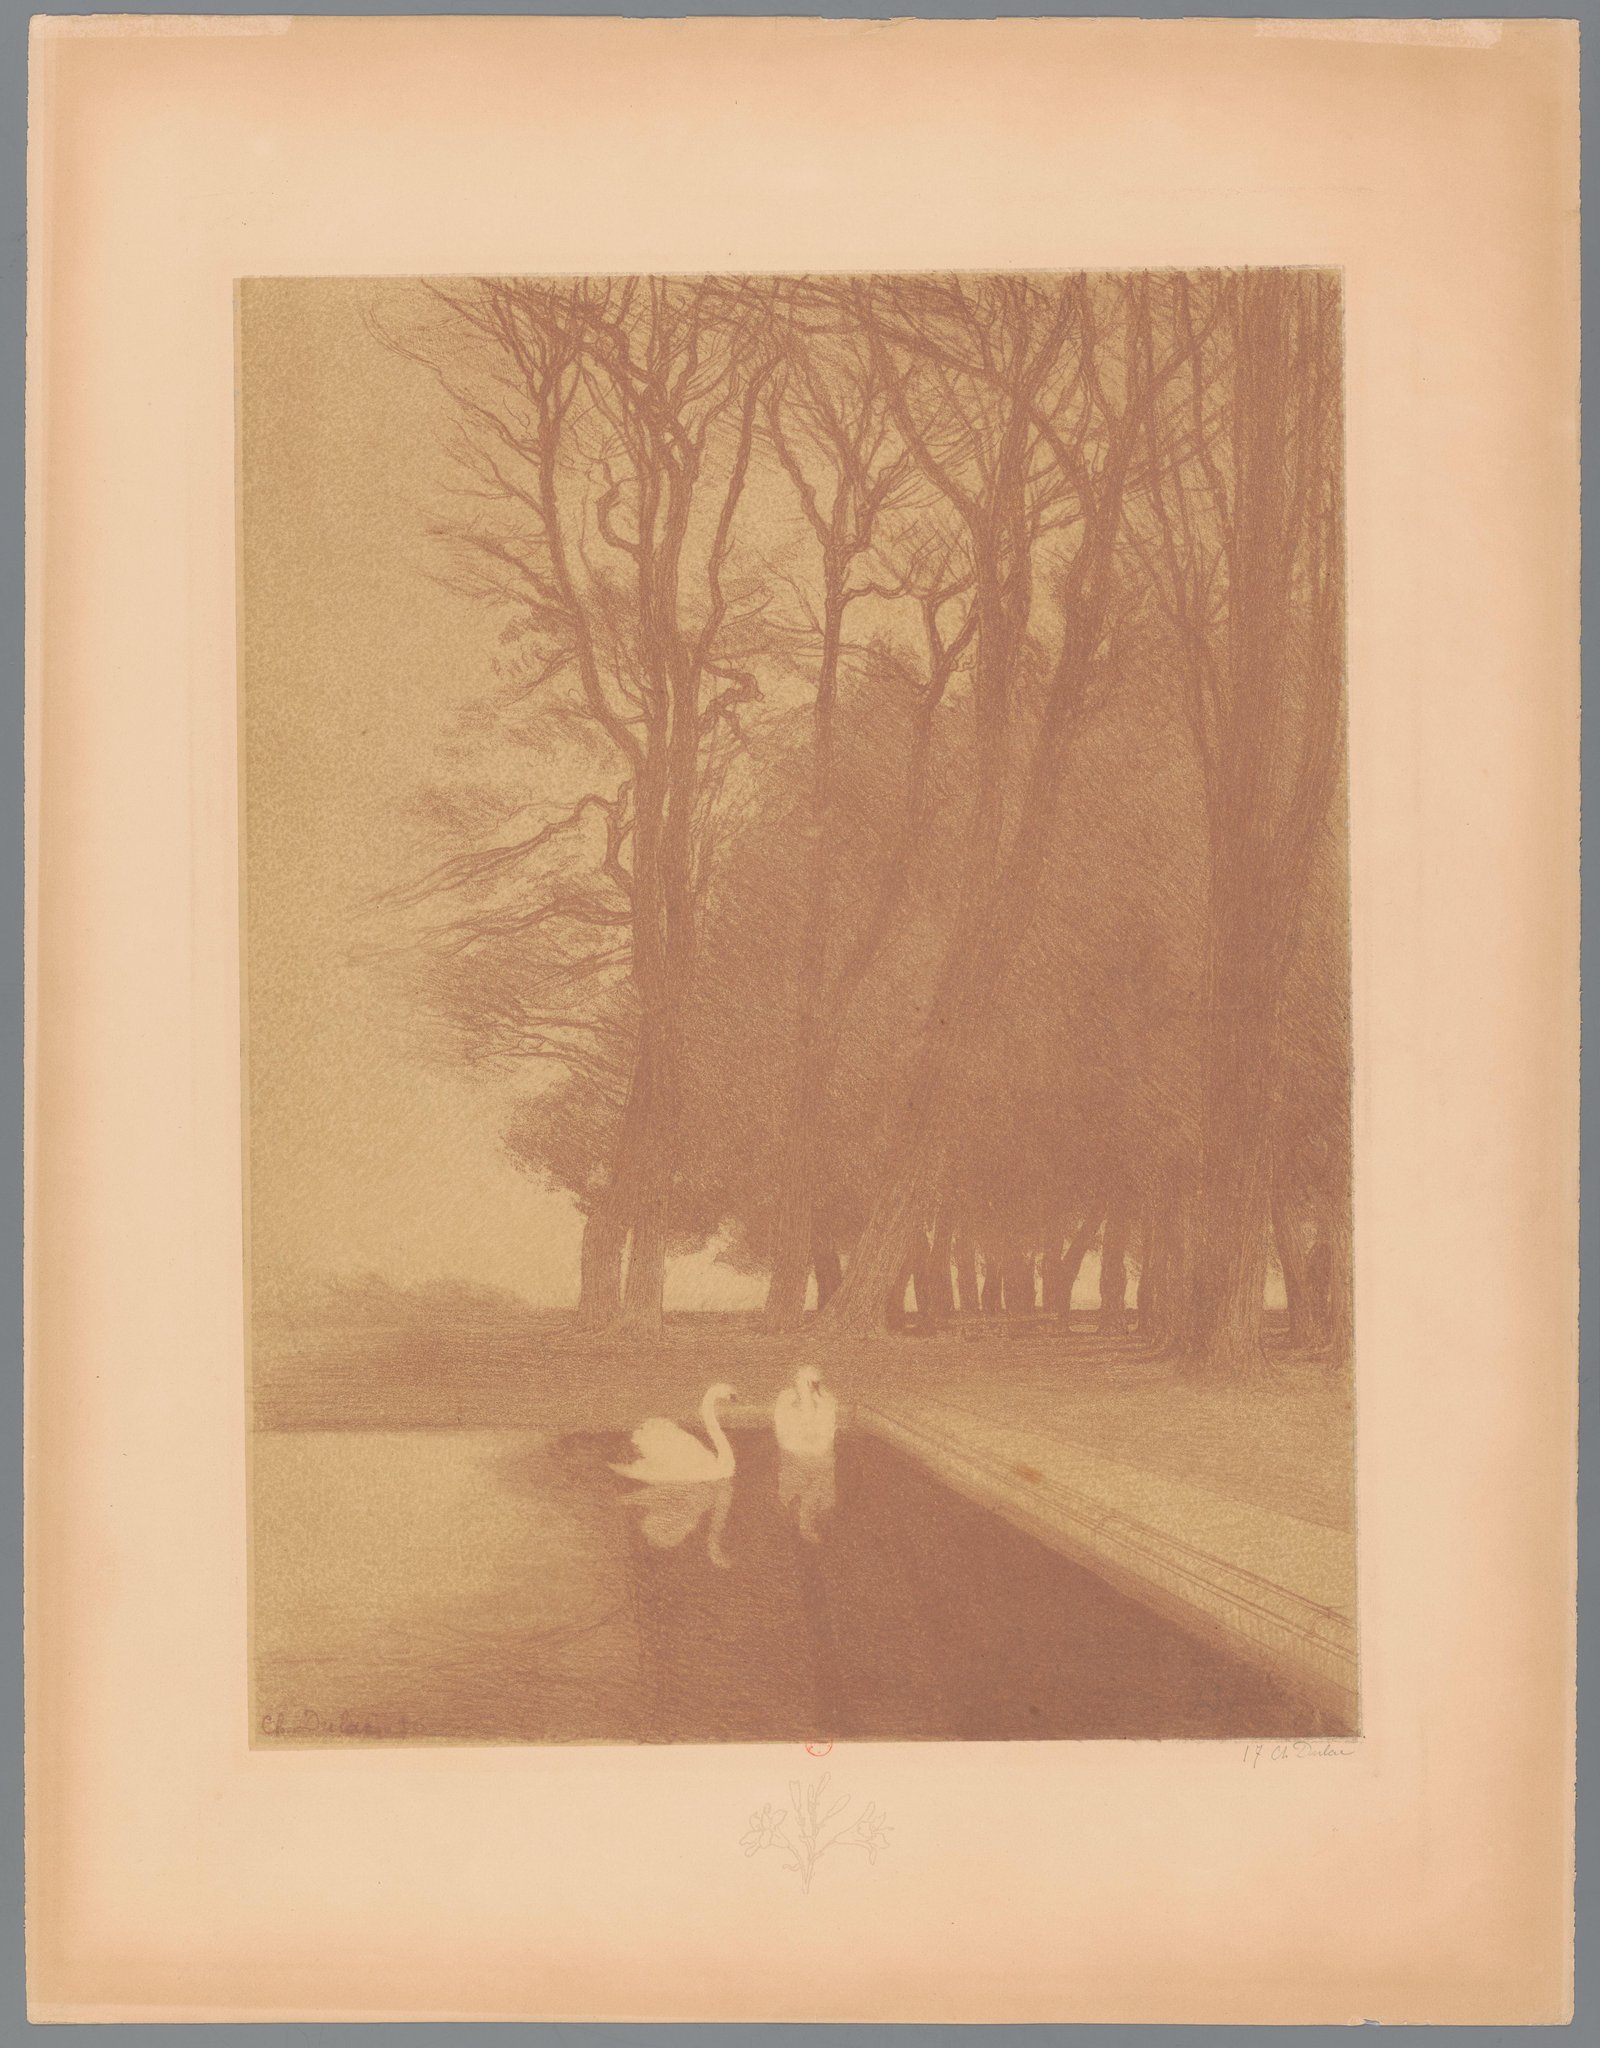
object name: print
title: Vijver met twee zwanen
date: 1892-1893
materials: paper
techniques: lithography, lithograph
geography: paris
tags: trees, water-birds: swan, pond, pool (+ landscape with figures, staffage)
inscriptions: stamp: ‘B.N. éch. 1976’, collector's mark: Lugt 249, collector's mark: Lugt 2228a, collector's mark: Lugt 2760